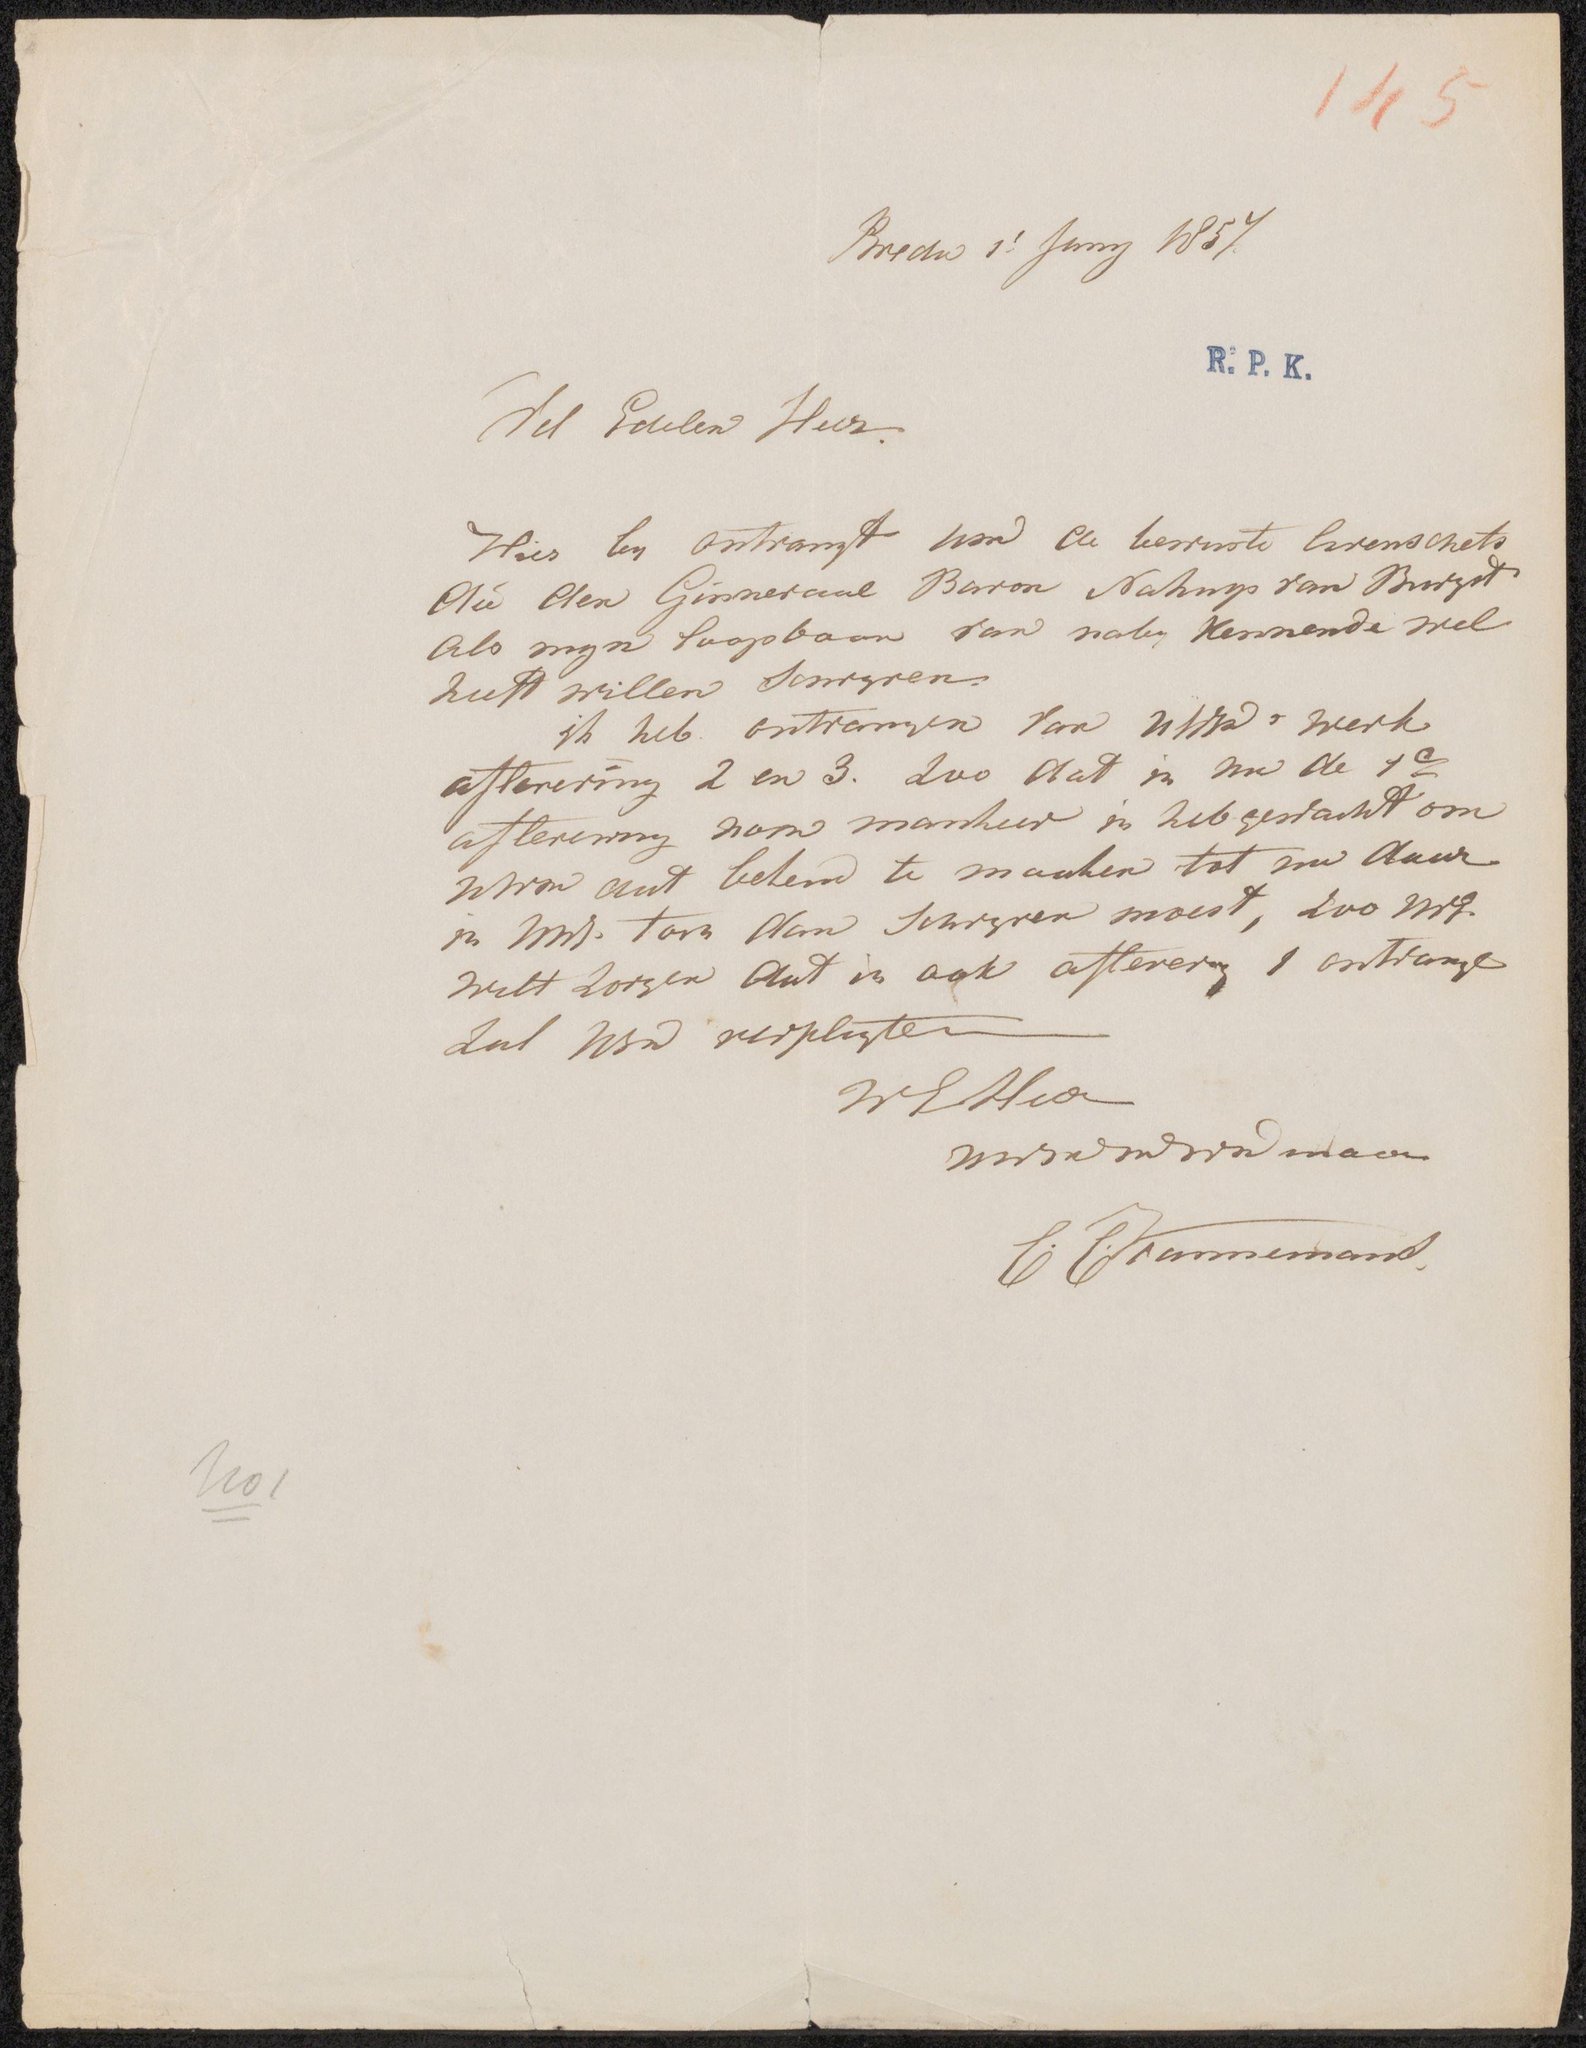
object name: letter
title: Brief aan Christiaan Kramm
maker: christiaan cornelis kannemans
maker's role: draughtsman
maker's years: 1812-1884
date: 1857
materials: ink, paper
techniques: pen, writing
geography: breda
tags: utrecht, print maker, christiaan kramm, printed matter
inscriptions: collector's mark: Lugt 2233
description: Bij de brief wordt een fotokopie van een levensbeschrijving van Christiaan Cornelis Kannemans door baron Huibert Gerard Nahuys van Burgst bewaard.